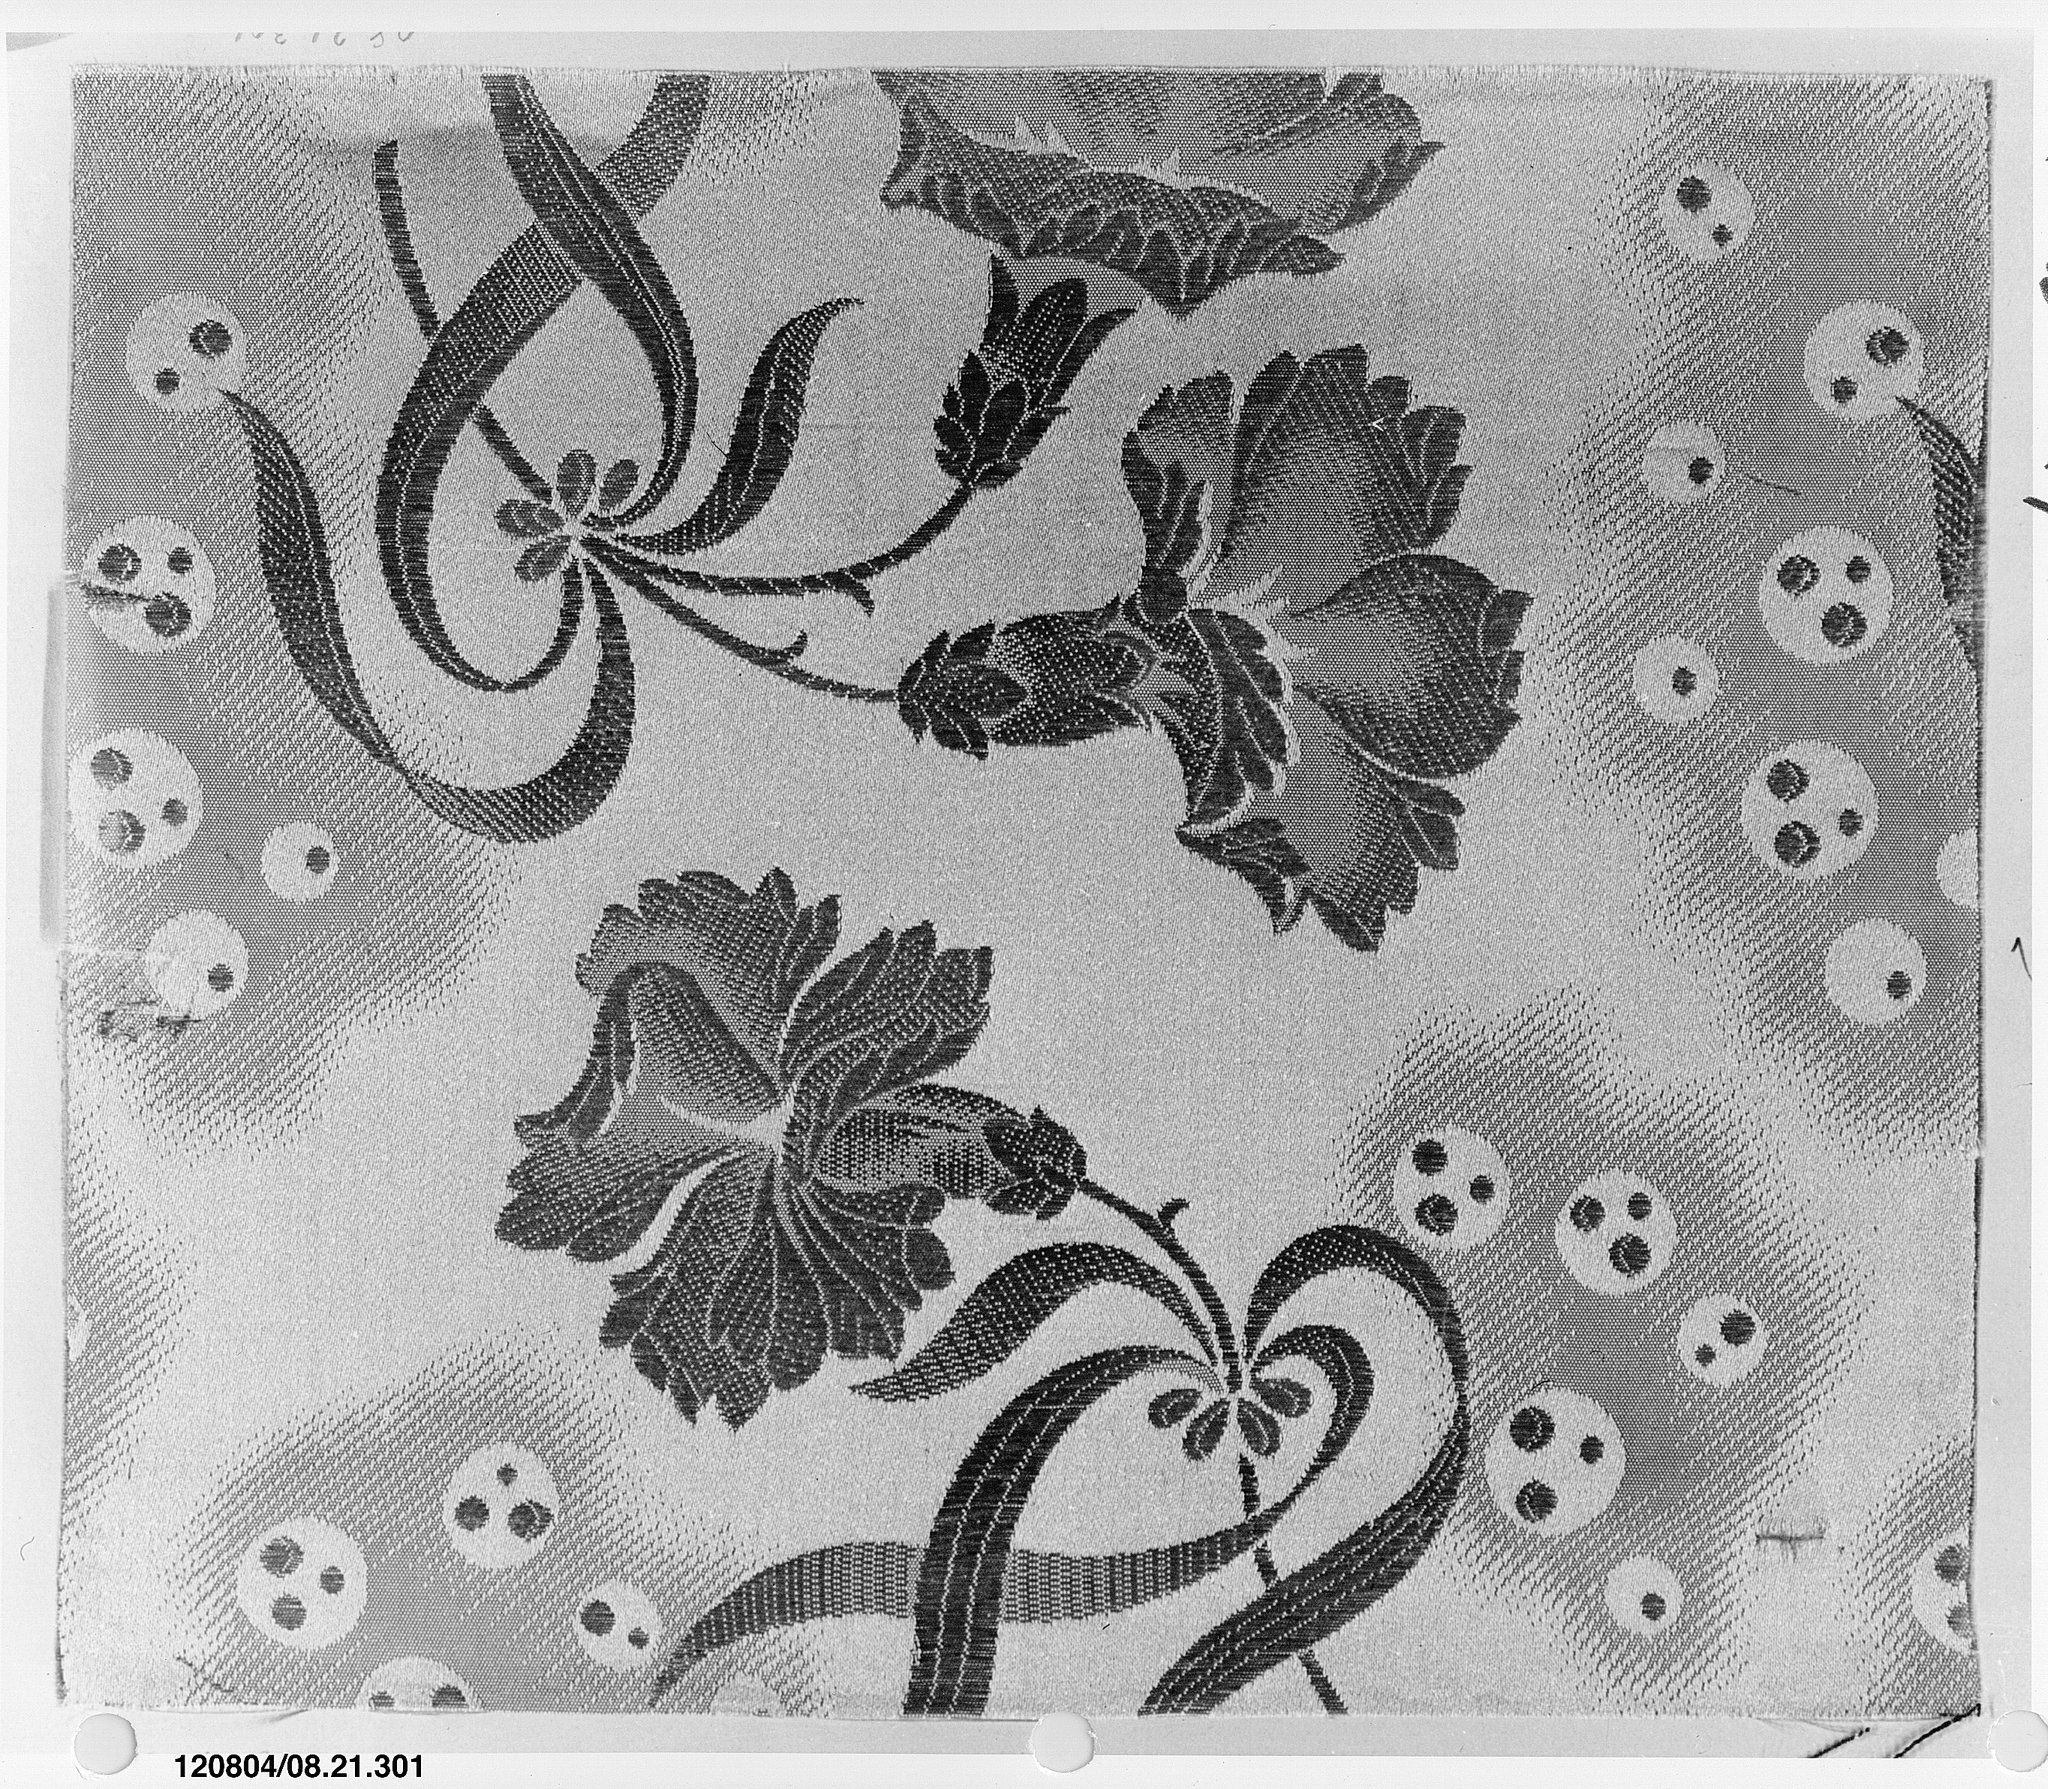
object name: textile sample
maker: Anonymous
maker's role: designer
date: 1900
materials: silk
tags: flowers